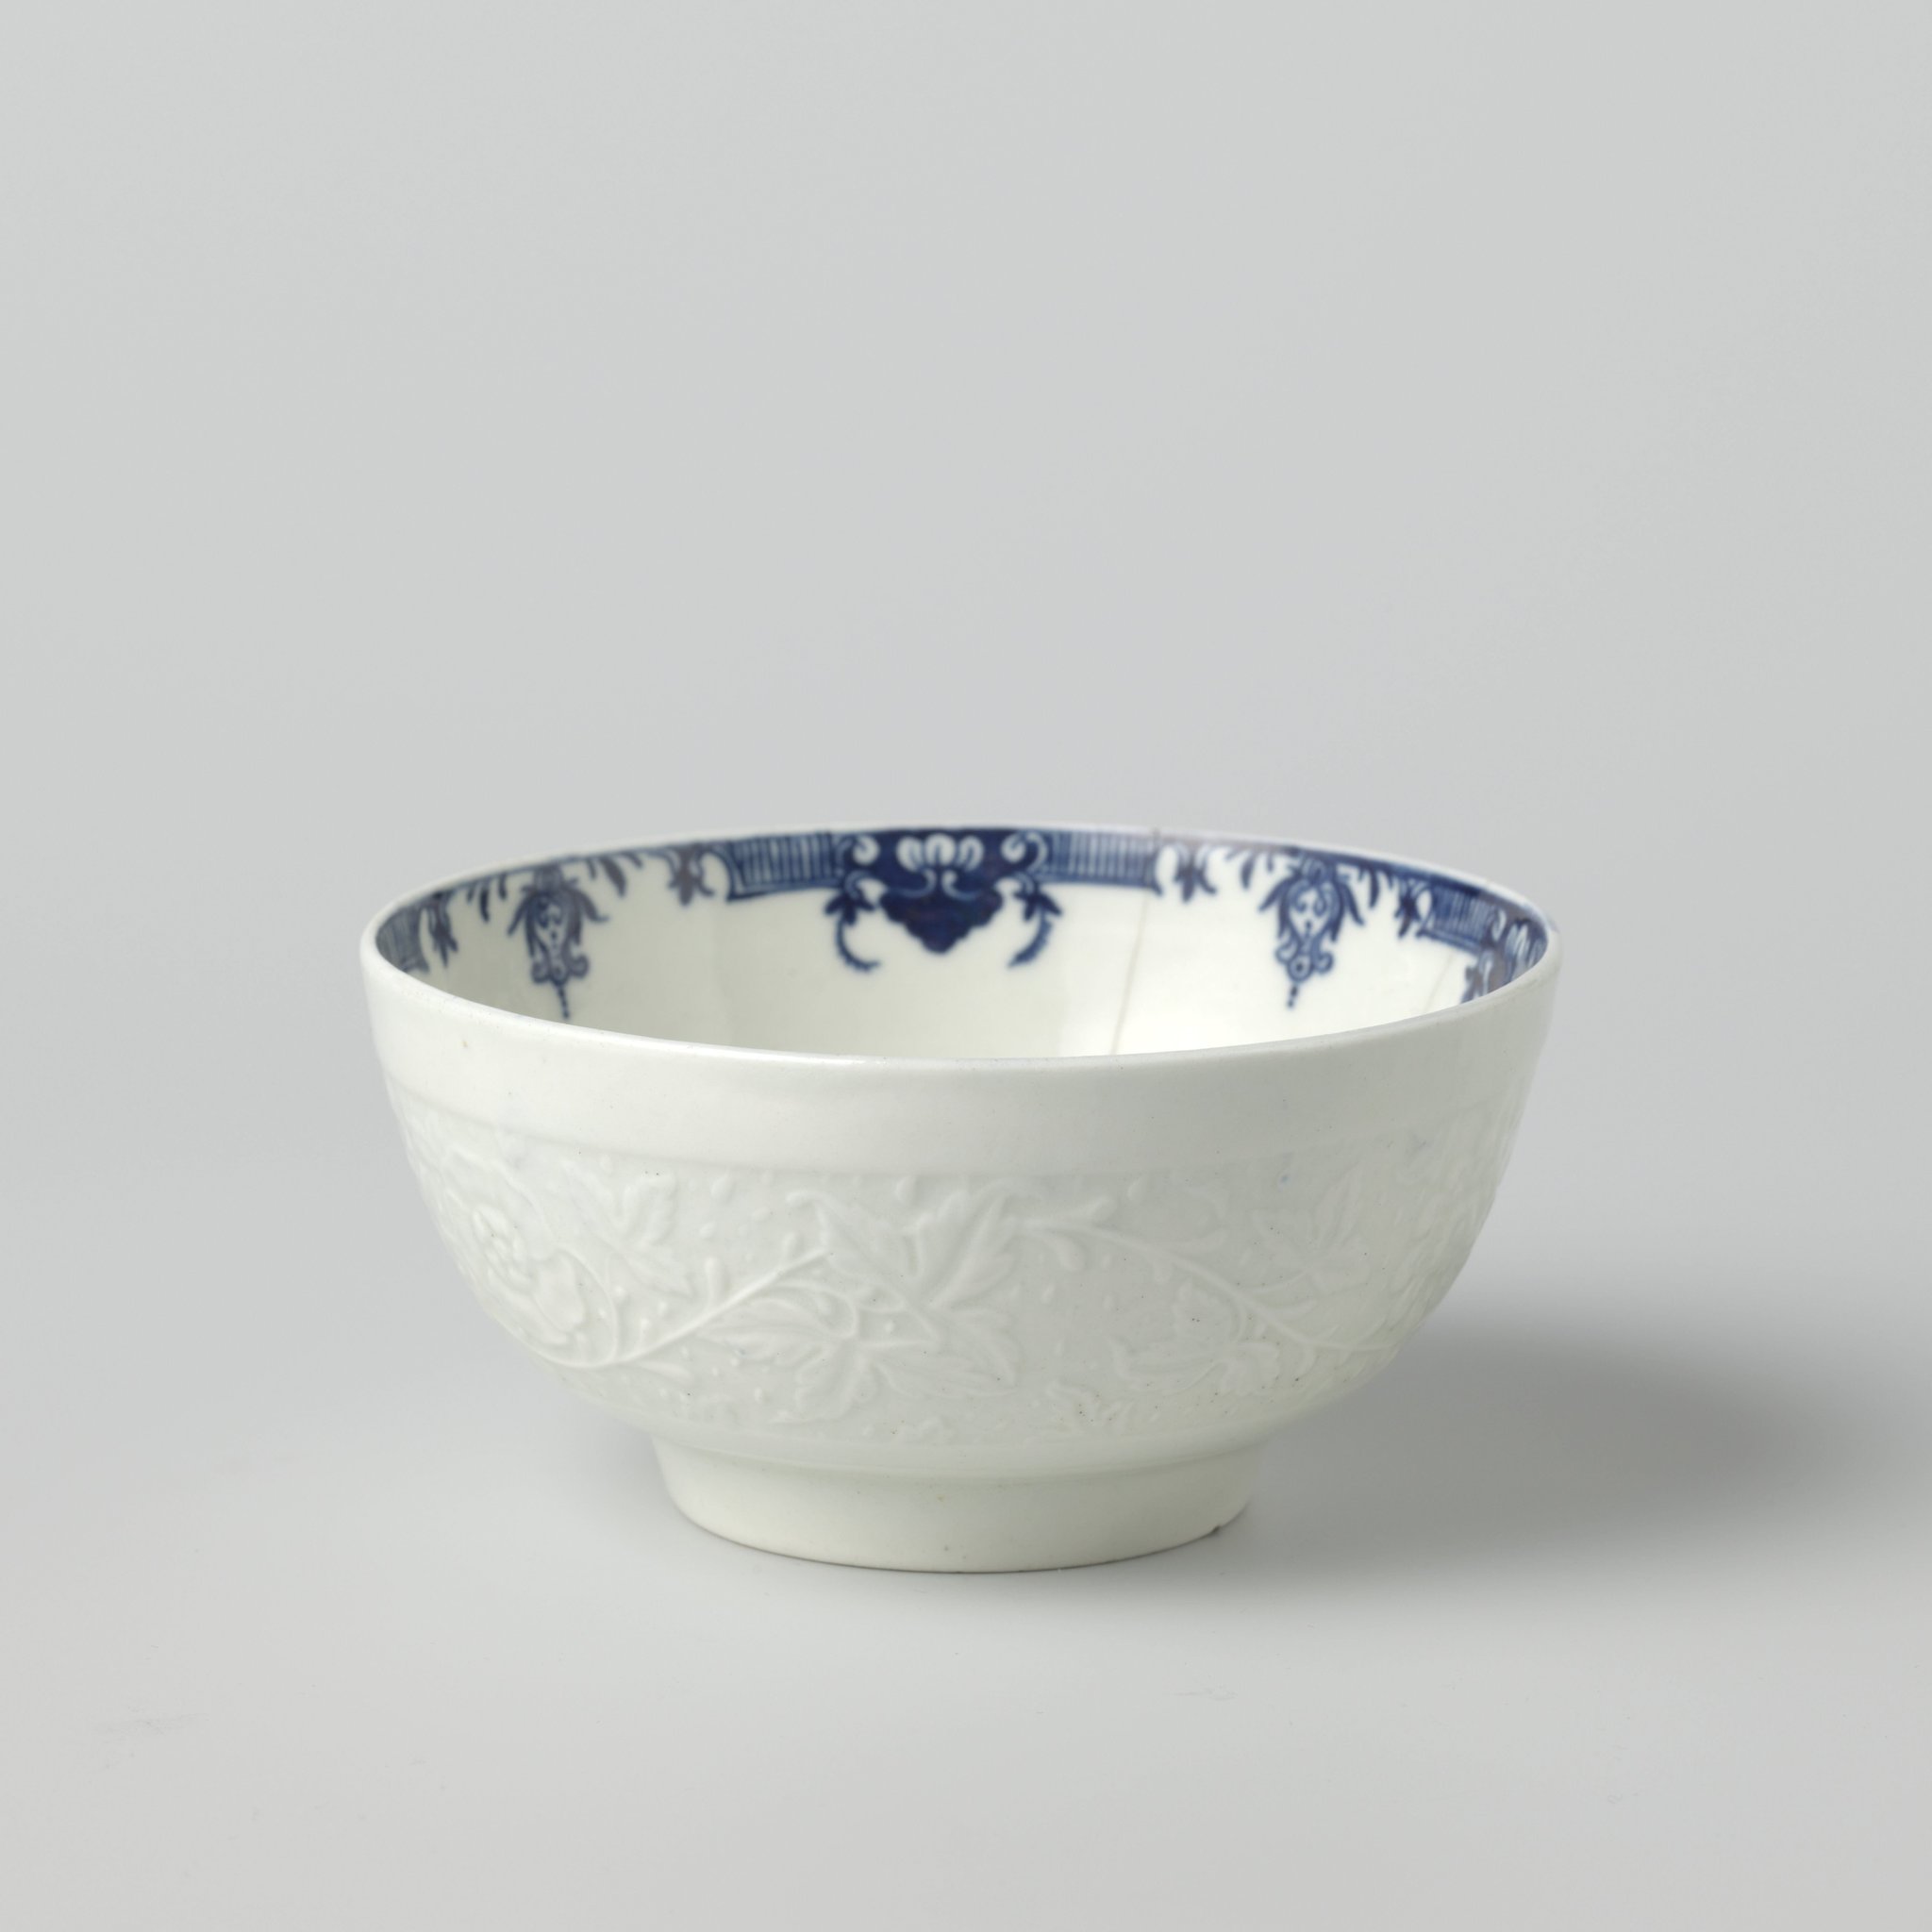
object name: bowl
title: Kom, wit, met aan binnenzijde een rand met rococo ornament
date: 1751-1783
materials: porcelain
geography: worcester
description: Kom van wit porselein, aan binnenzijde langs de bovenrand versierd met een rococo ornament in blauw. Op het plat een blauwe aster. Buitenzijde met reliëfversiering van een rank met bladeren en bloemen. Gemerkt onder aan de voet: C. Opmerking: gerestaureerd.